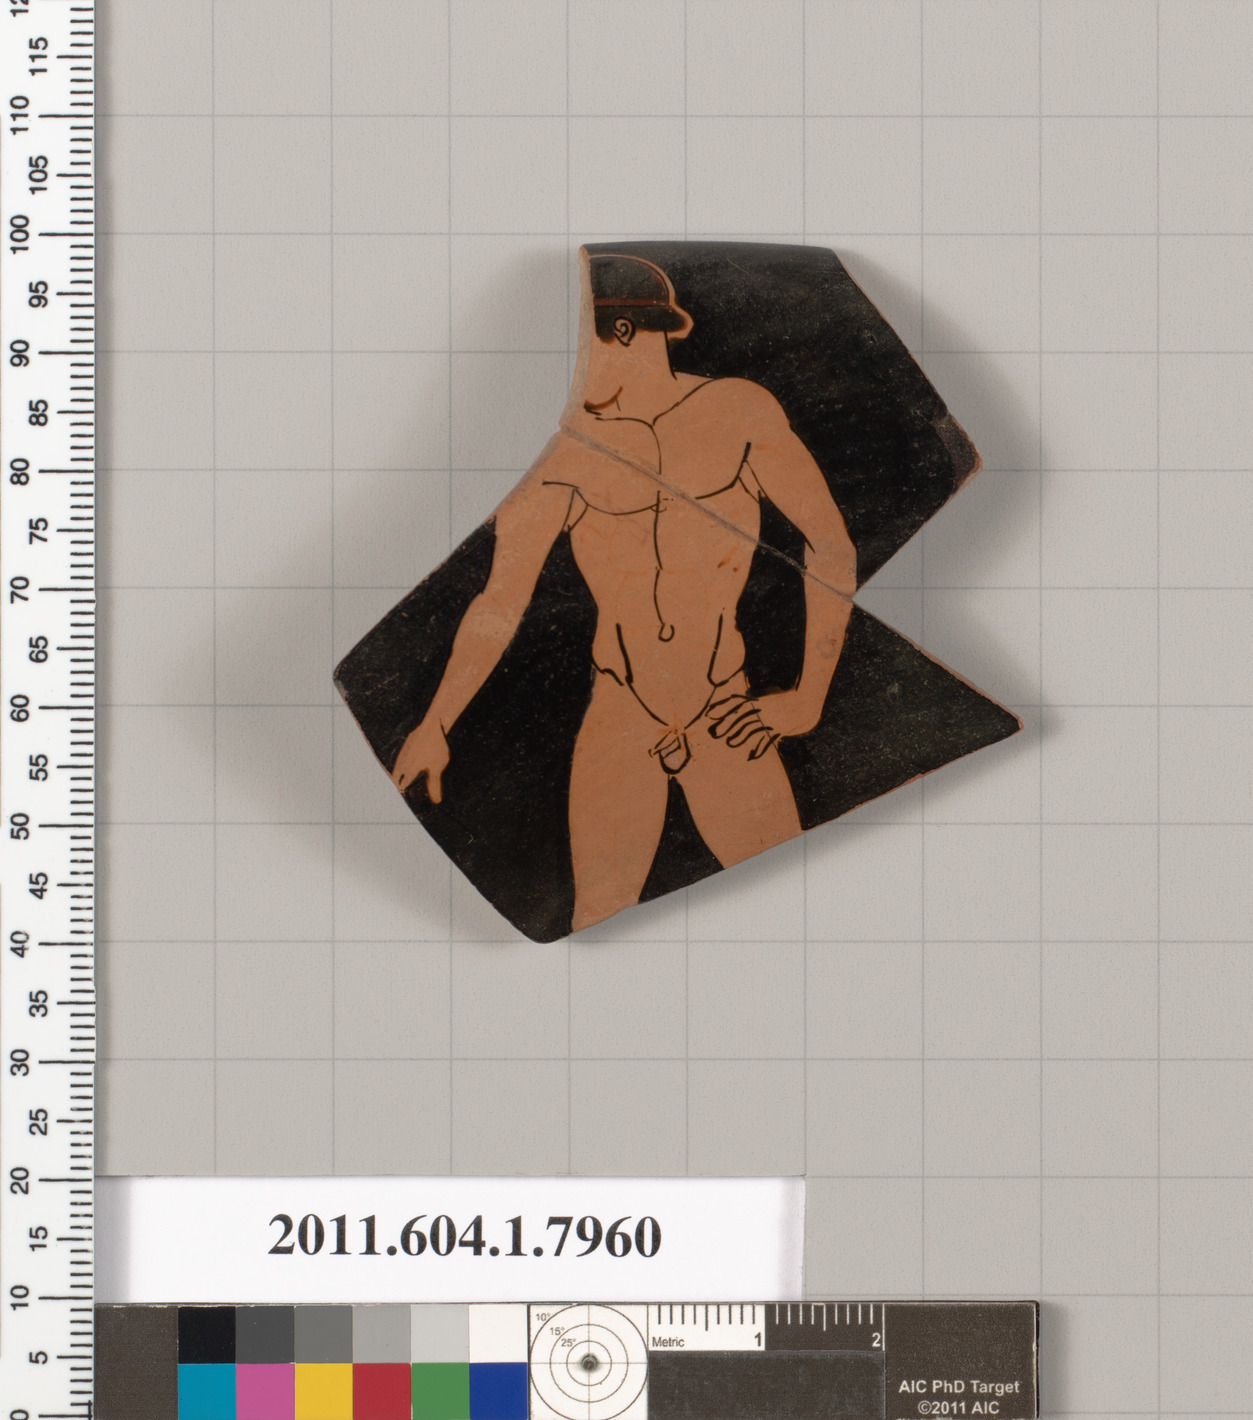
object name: kylix fragment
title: Terracotta rim fragment of a kylix (drinking cup)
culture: greek, attic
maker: euaichme painter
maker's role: artist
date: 460-450 BCE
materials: terracotta